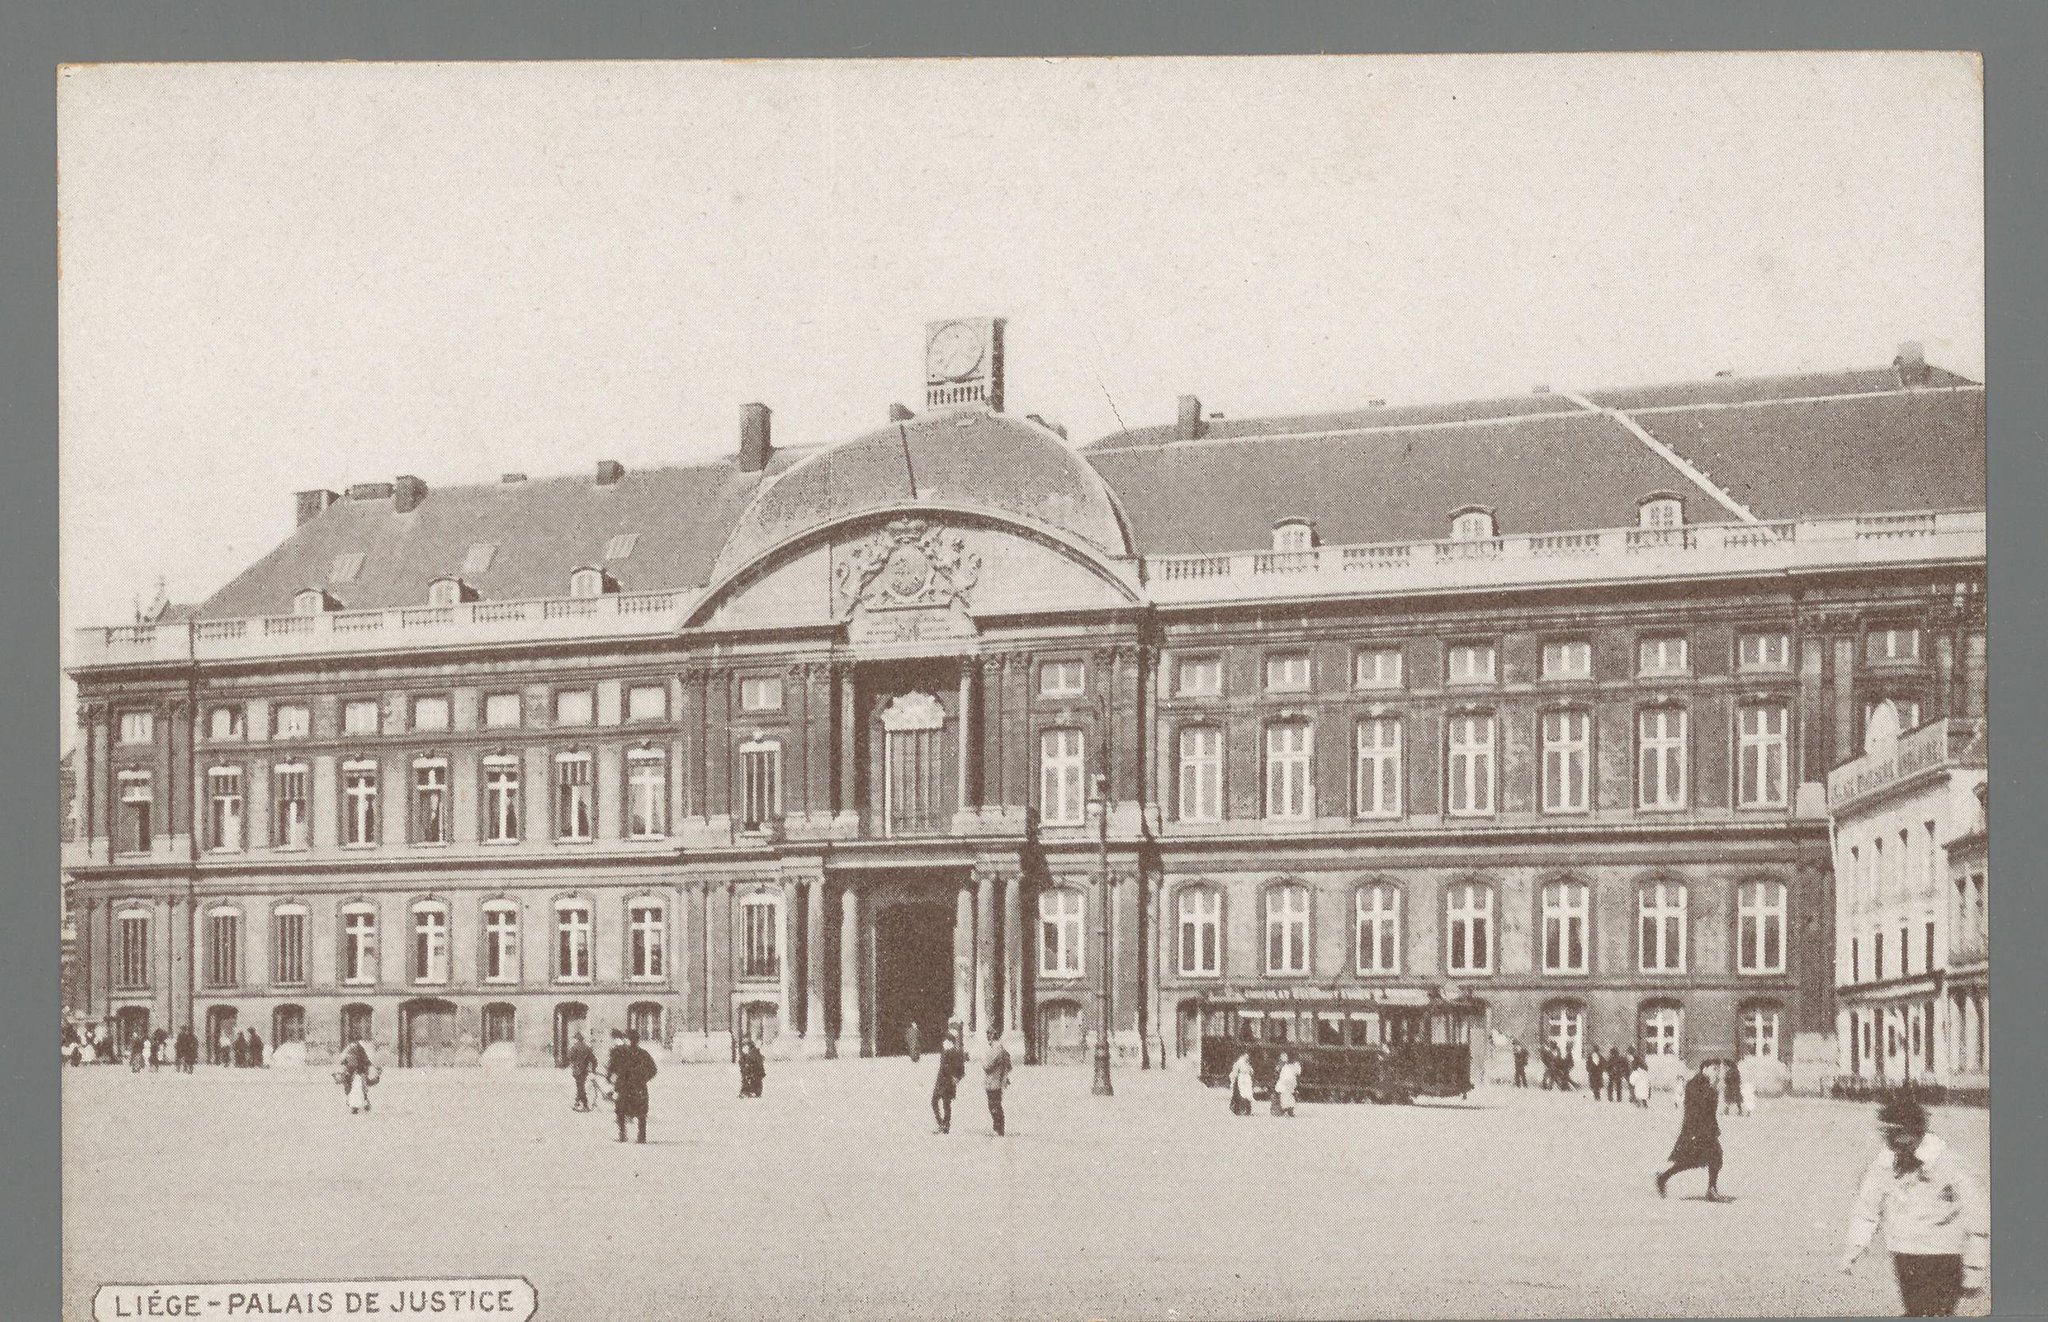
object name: photomechanical print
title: Liège. Palais de Justice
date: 1909-1913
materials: cardboard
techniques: autotype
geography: antwerp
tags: court building, square, place, circus, etc. (+ city(-scape) with figures, staffage), liège